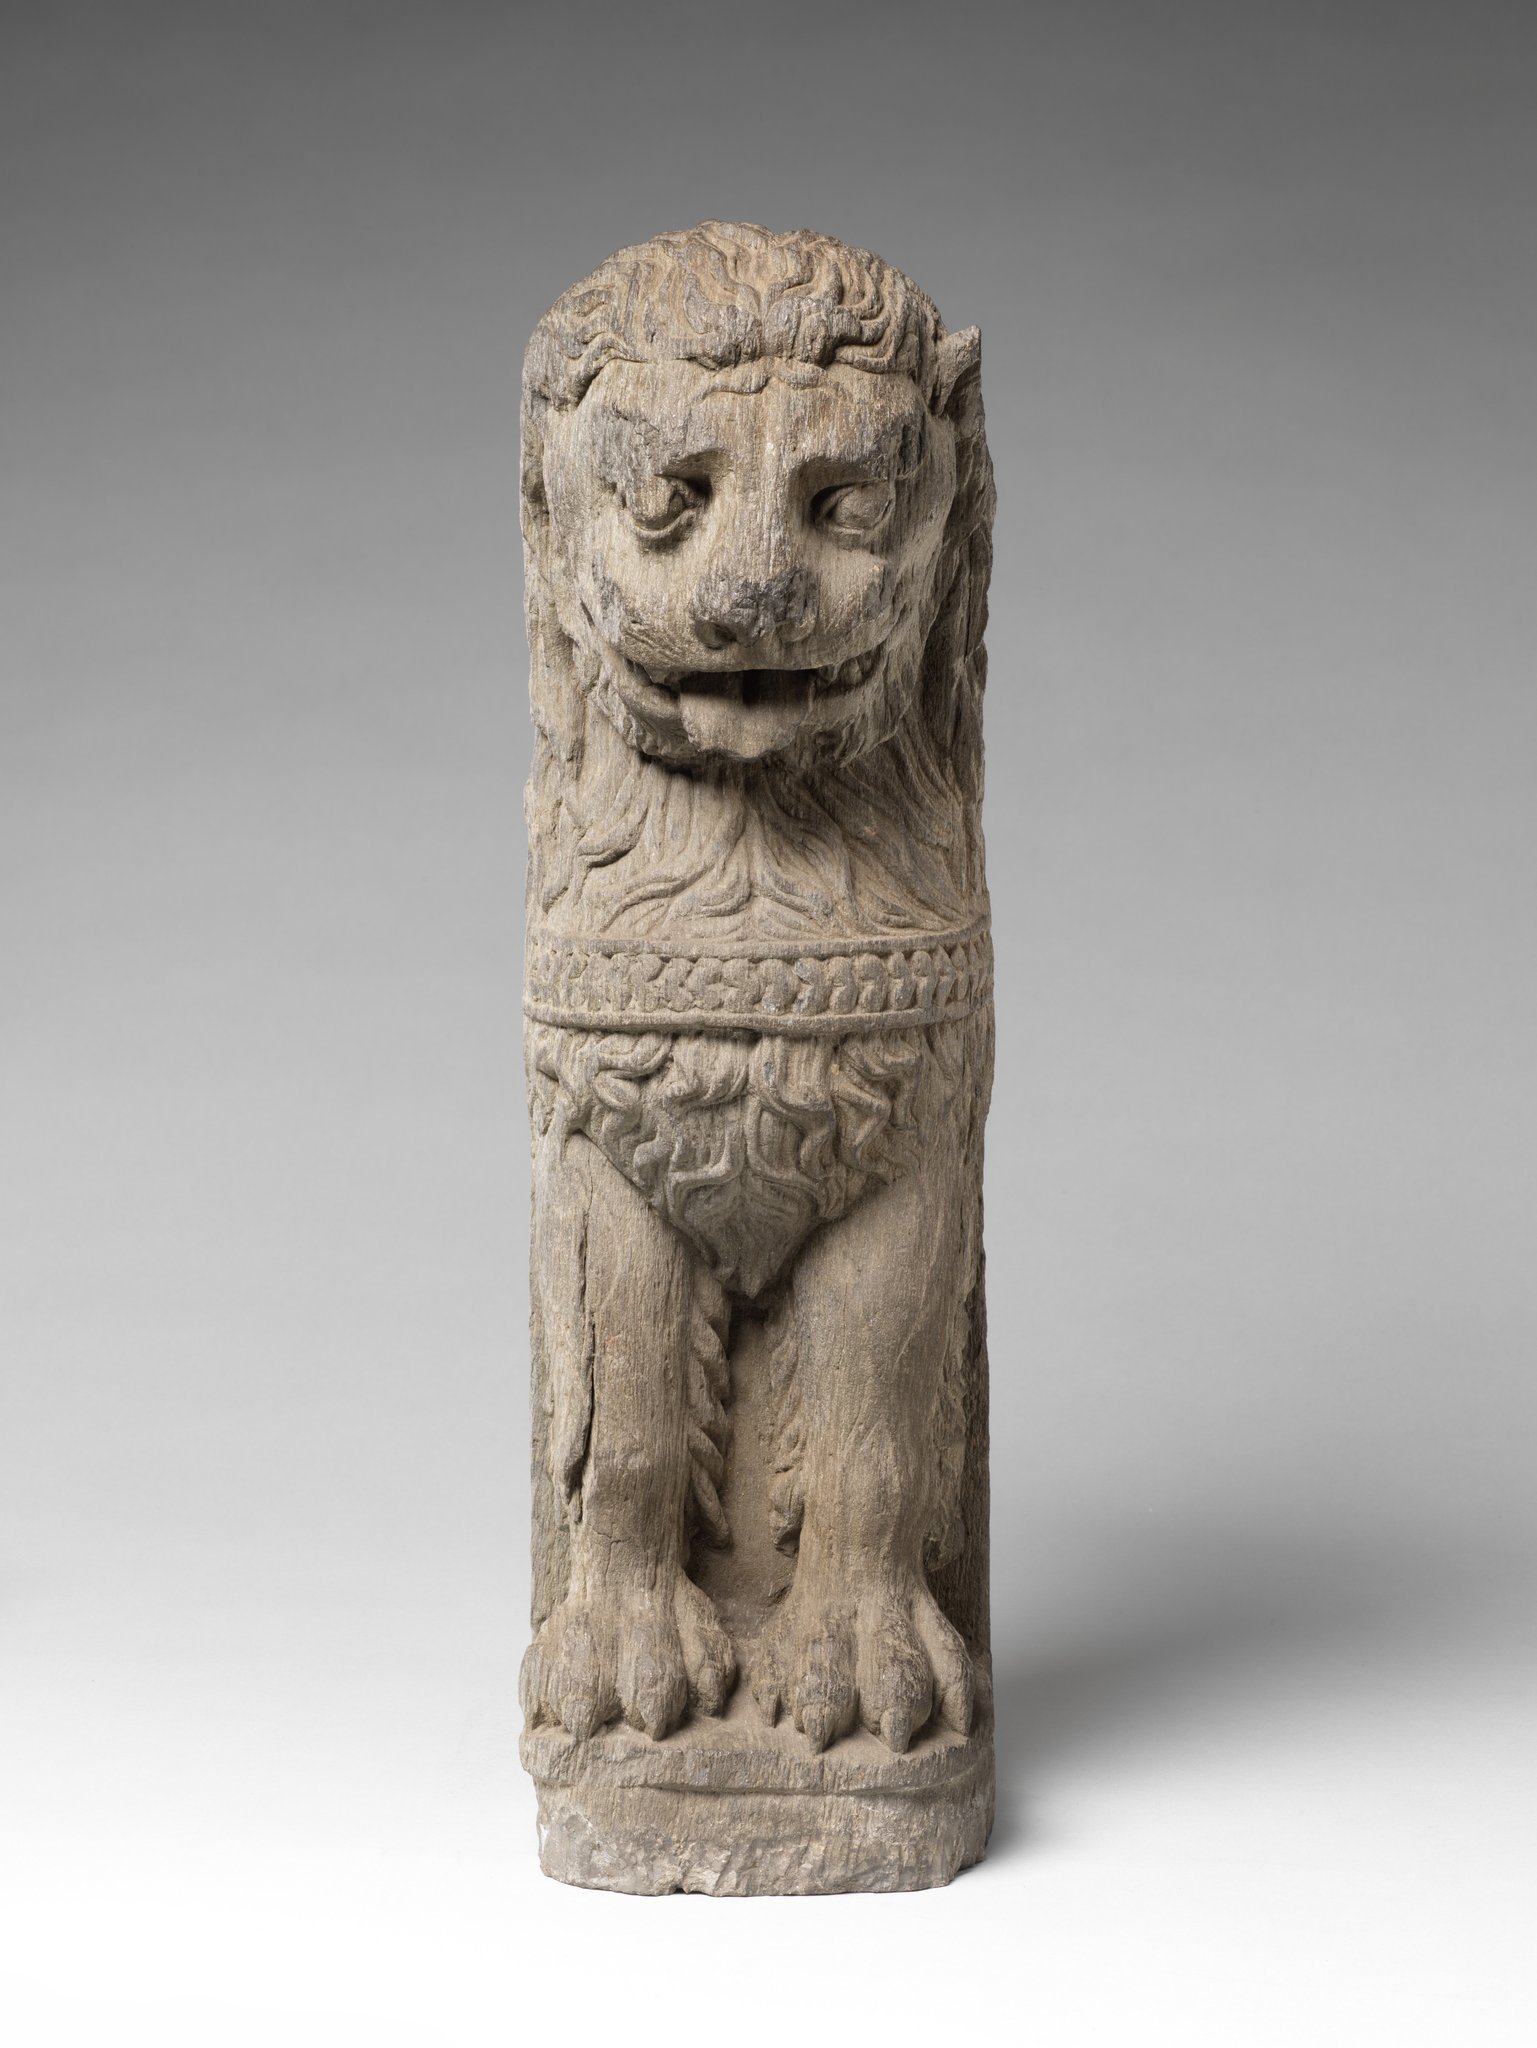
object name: lion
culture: gandhara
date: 101-300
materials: stone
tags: gandhara,lions